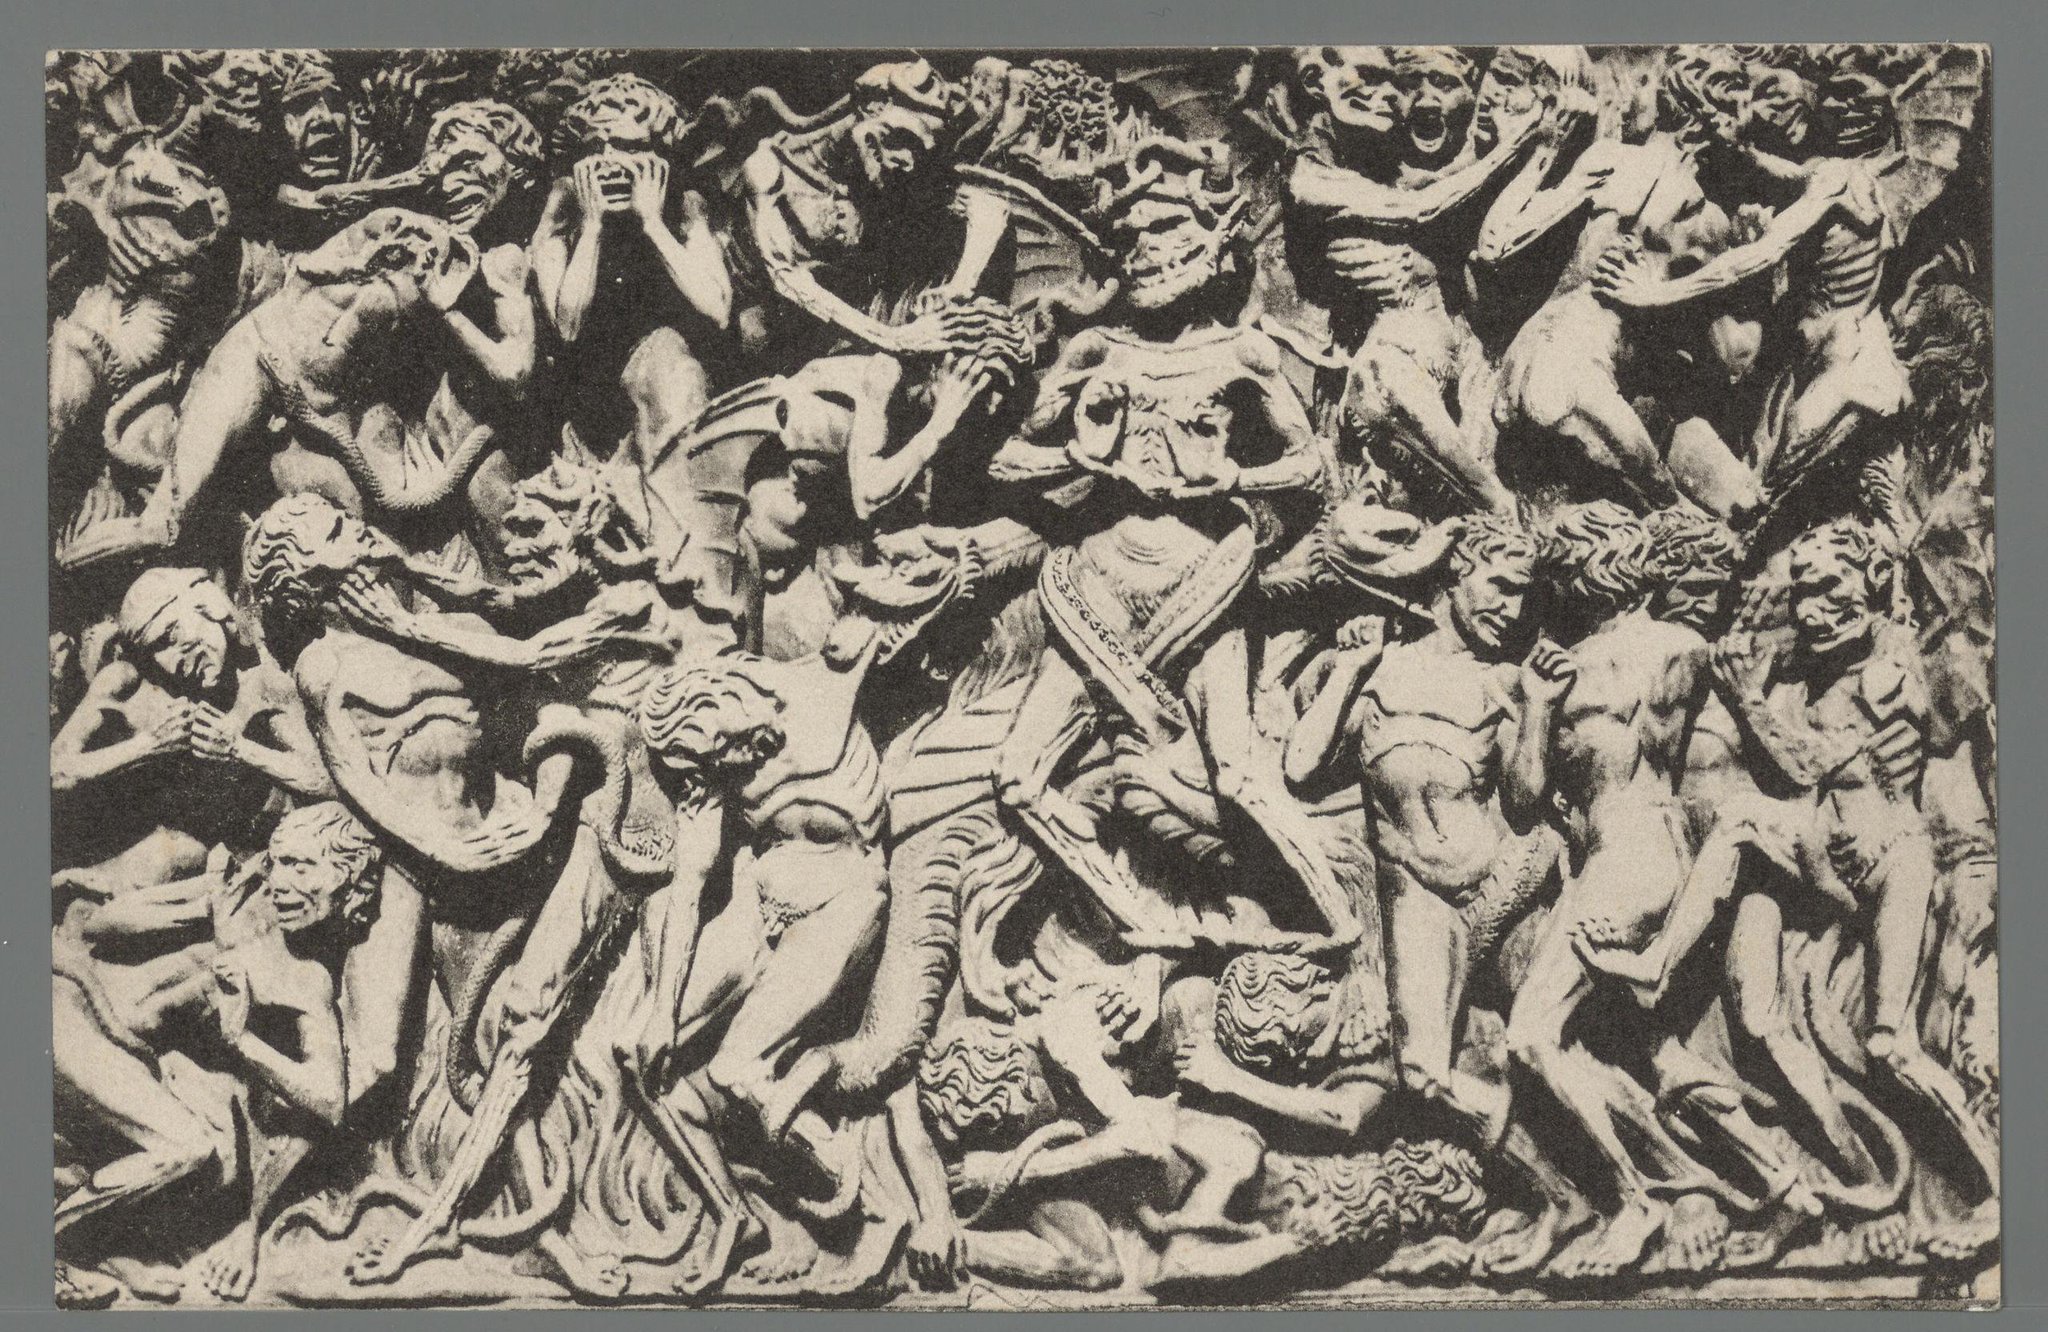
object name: ansichtkaart, prentbriefkaart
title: Orvieto. Cattedrale. Dettaglio della Facciata (Interno)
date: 1906-1930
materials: cardboard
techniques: photograph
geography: orvieto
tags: church (exterior)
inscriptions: collector's mark: ‘AFE v S’